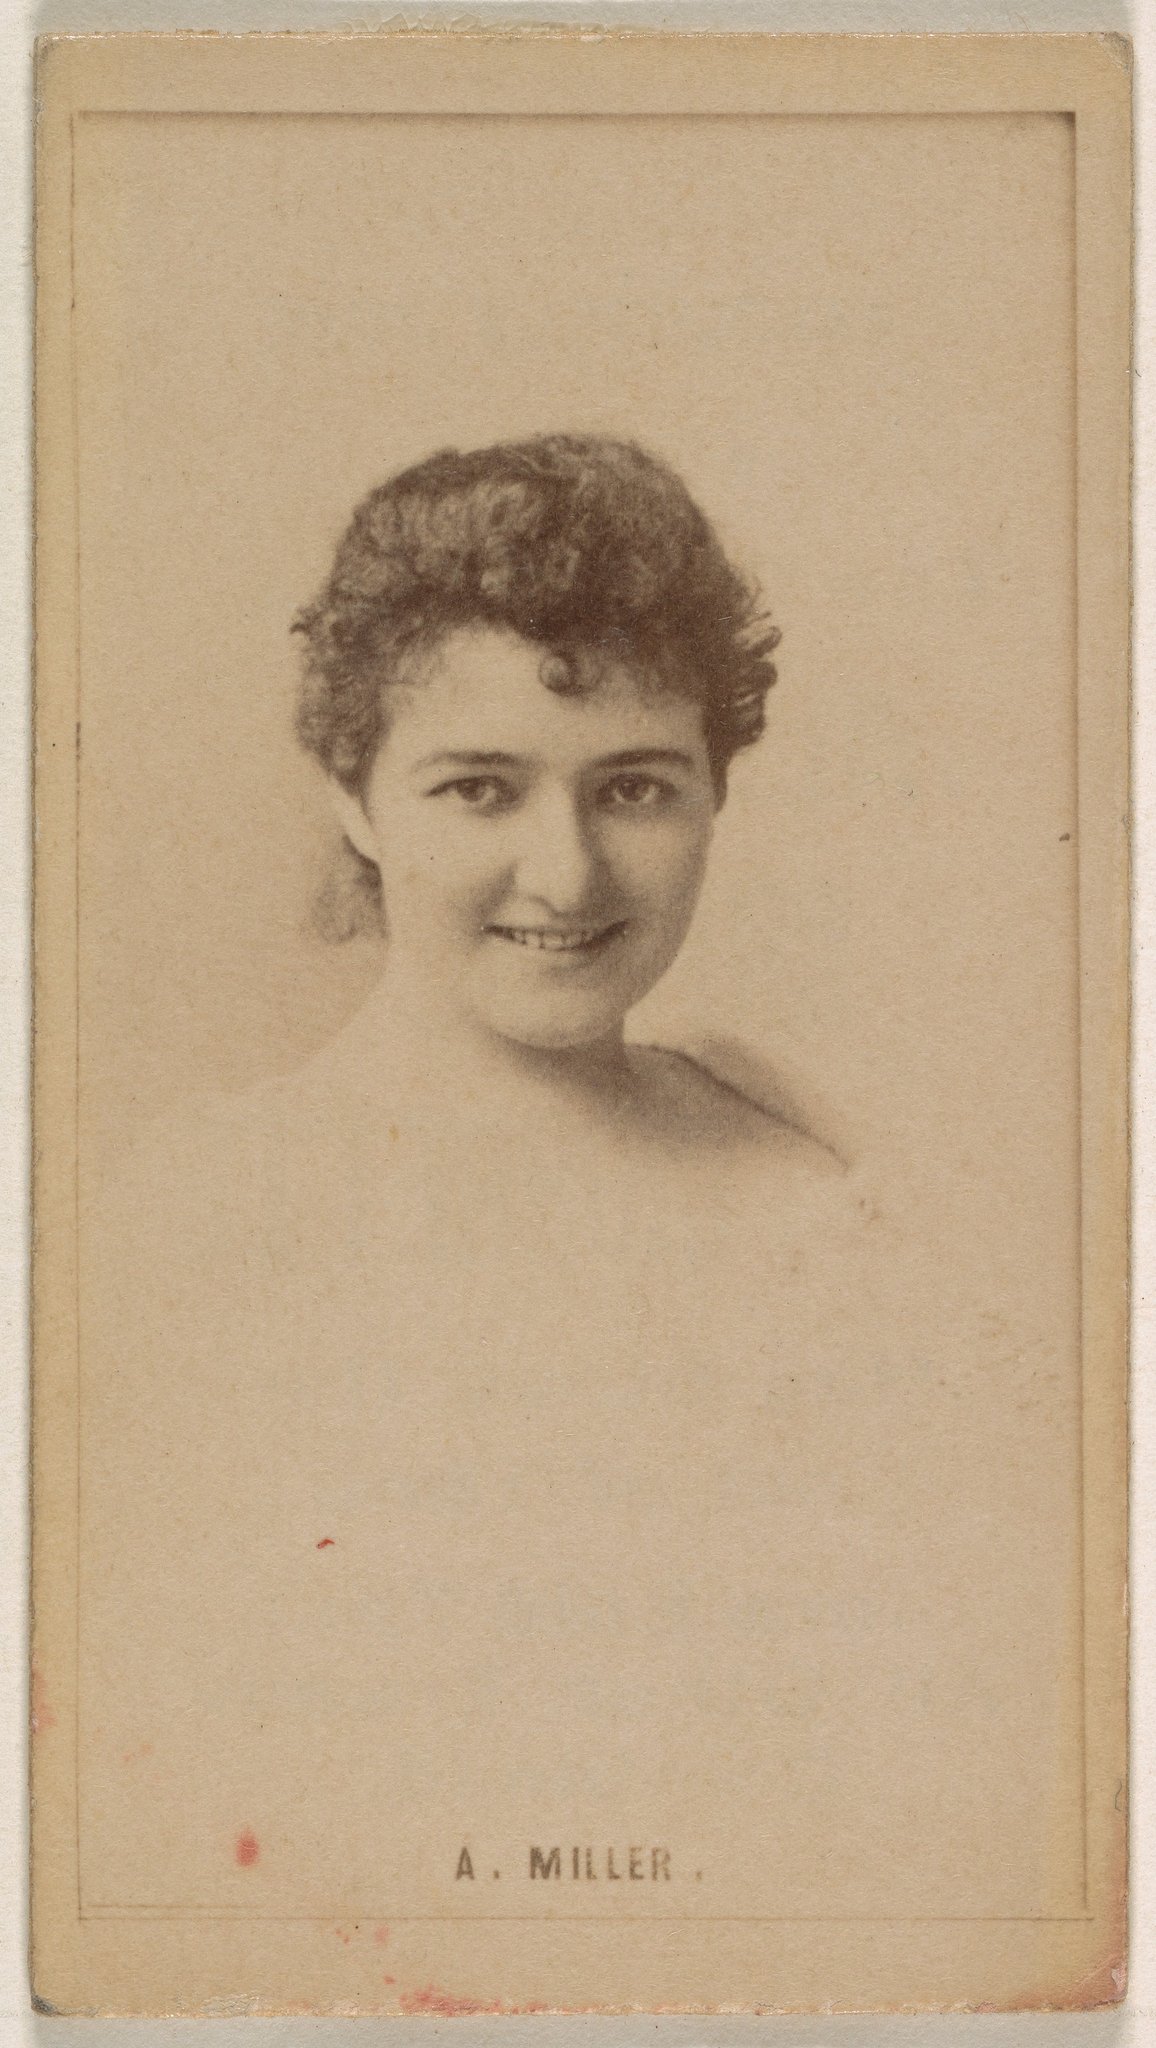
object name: photograph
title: Agnes Miller, from the Actresses series (N245) issued by Kinney Brothers to promote Sweet Caporal Cigarettes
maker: kinney brothers tobacco company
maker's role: publisher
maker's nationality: american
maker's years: 1869-2011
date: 1890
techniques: albumen silver print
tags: portraits,women,actresses